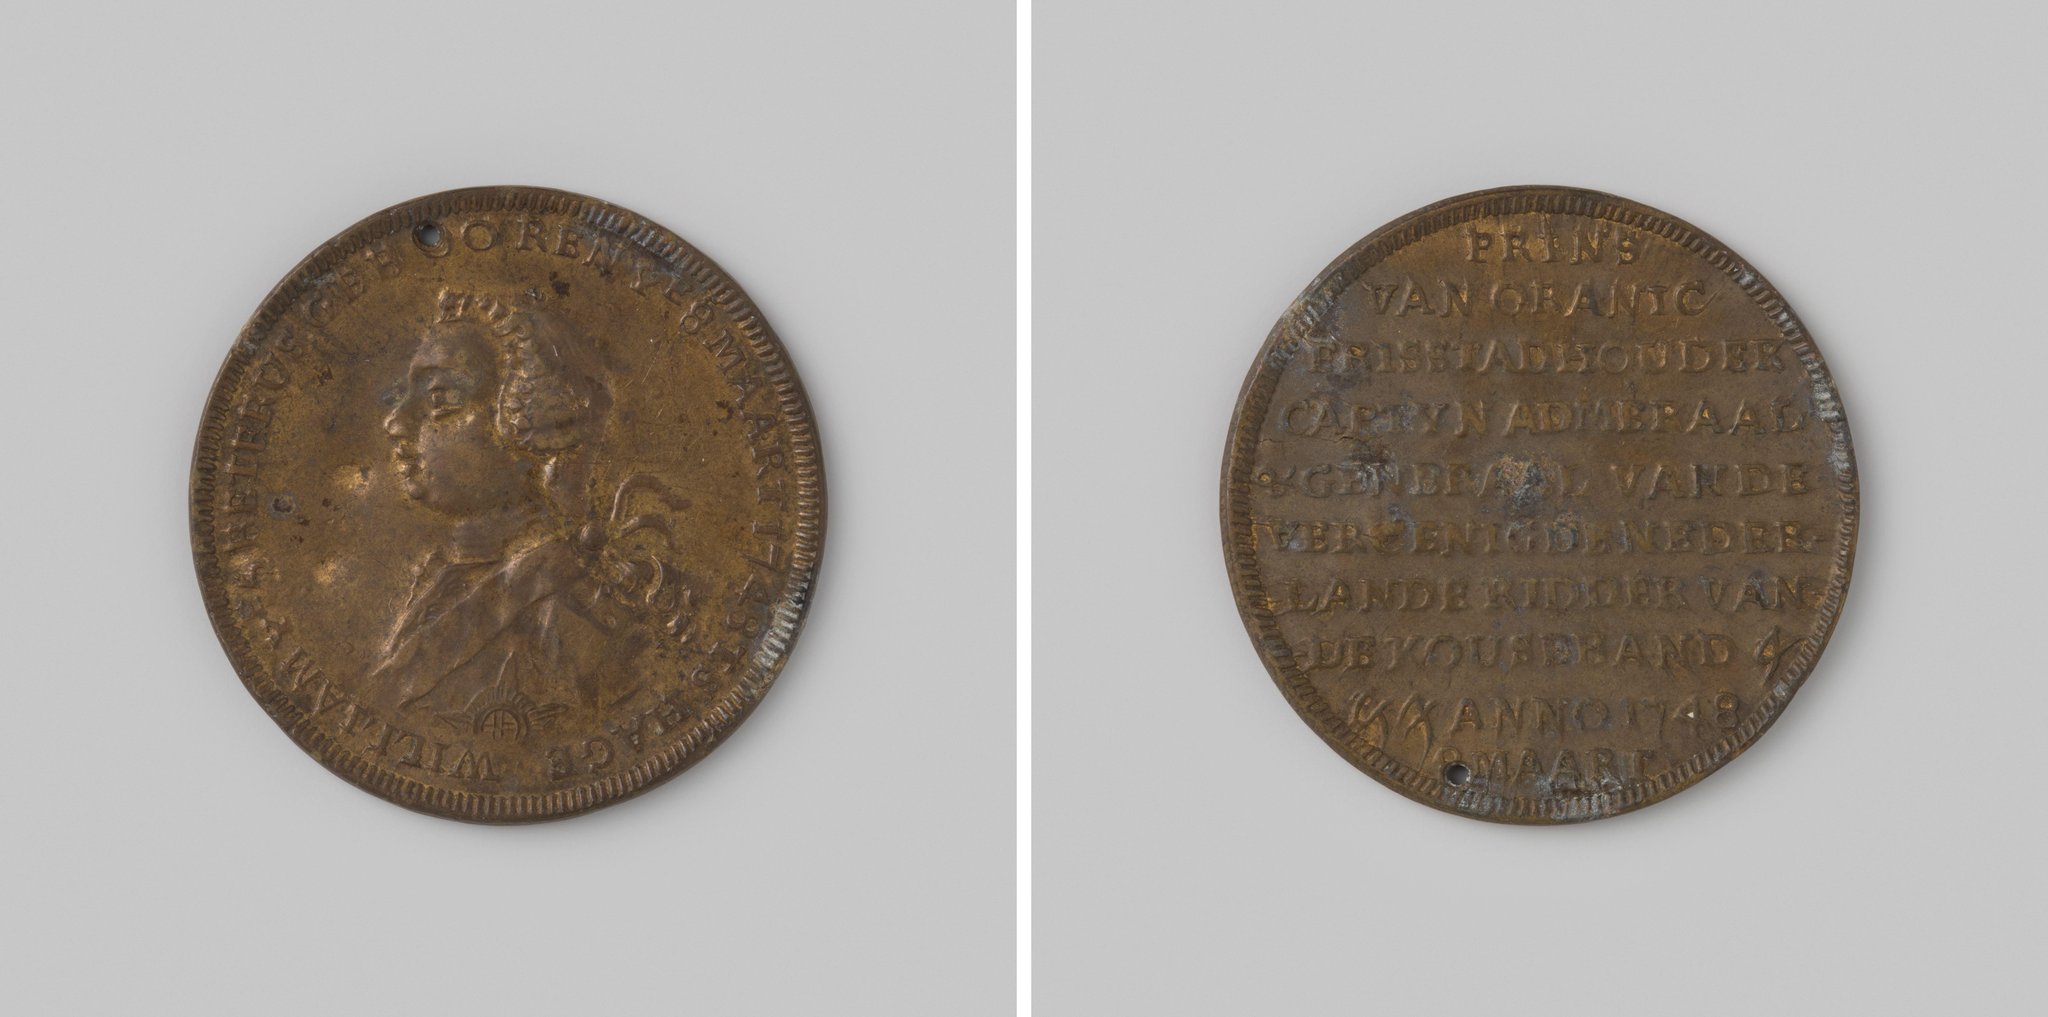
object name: history medal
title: Willem V, prins van Oranje-Nassau, erfstadhouder der Verenigde Nederlanden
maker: Anonymous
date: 1752-1766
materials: copper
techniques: striking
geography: england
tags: the hague, william v (prince of orange)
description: Koperen penning. Voorzijde: borststuk man binnen omschrift. Keerzijde: opschrift